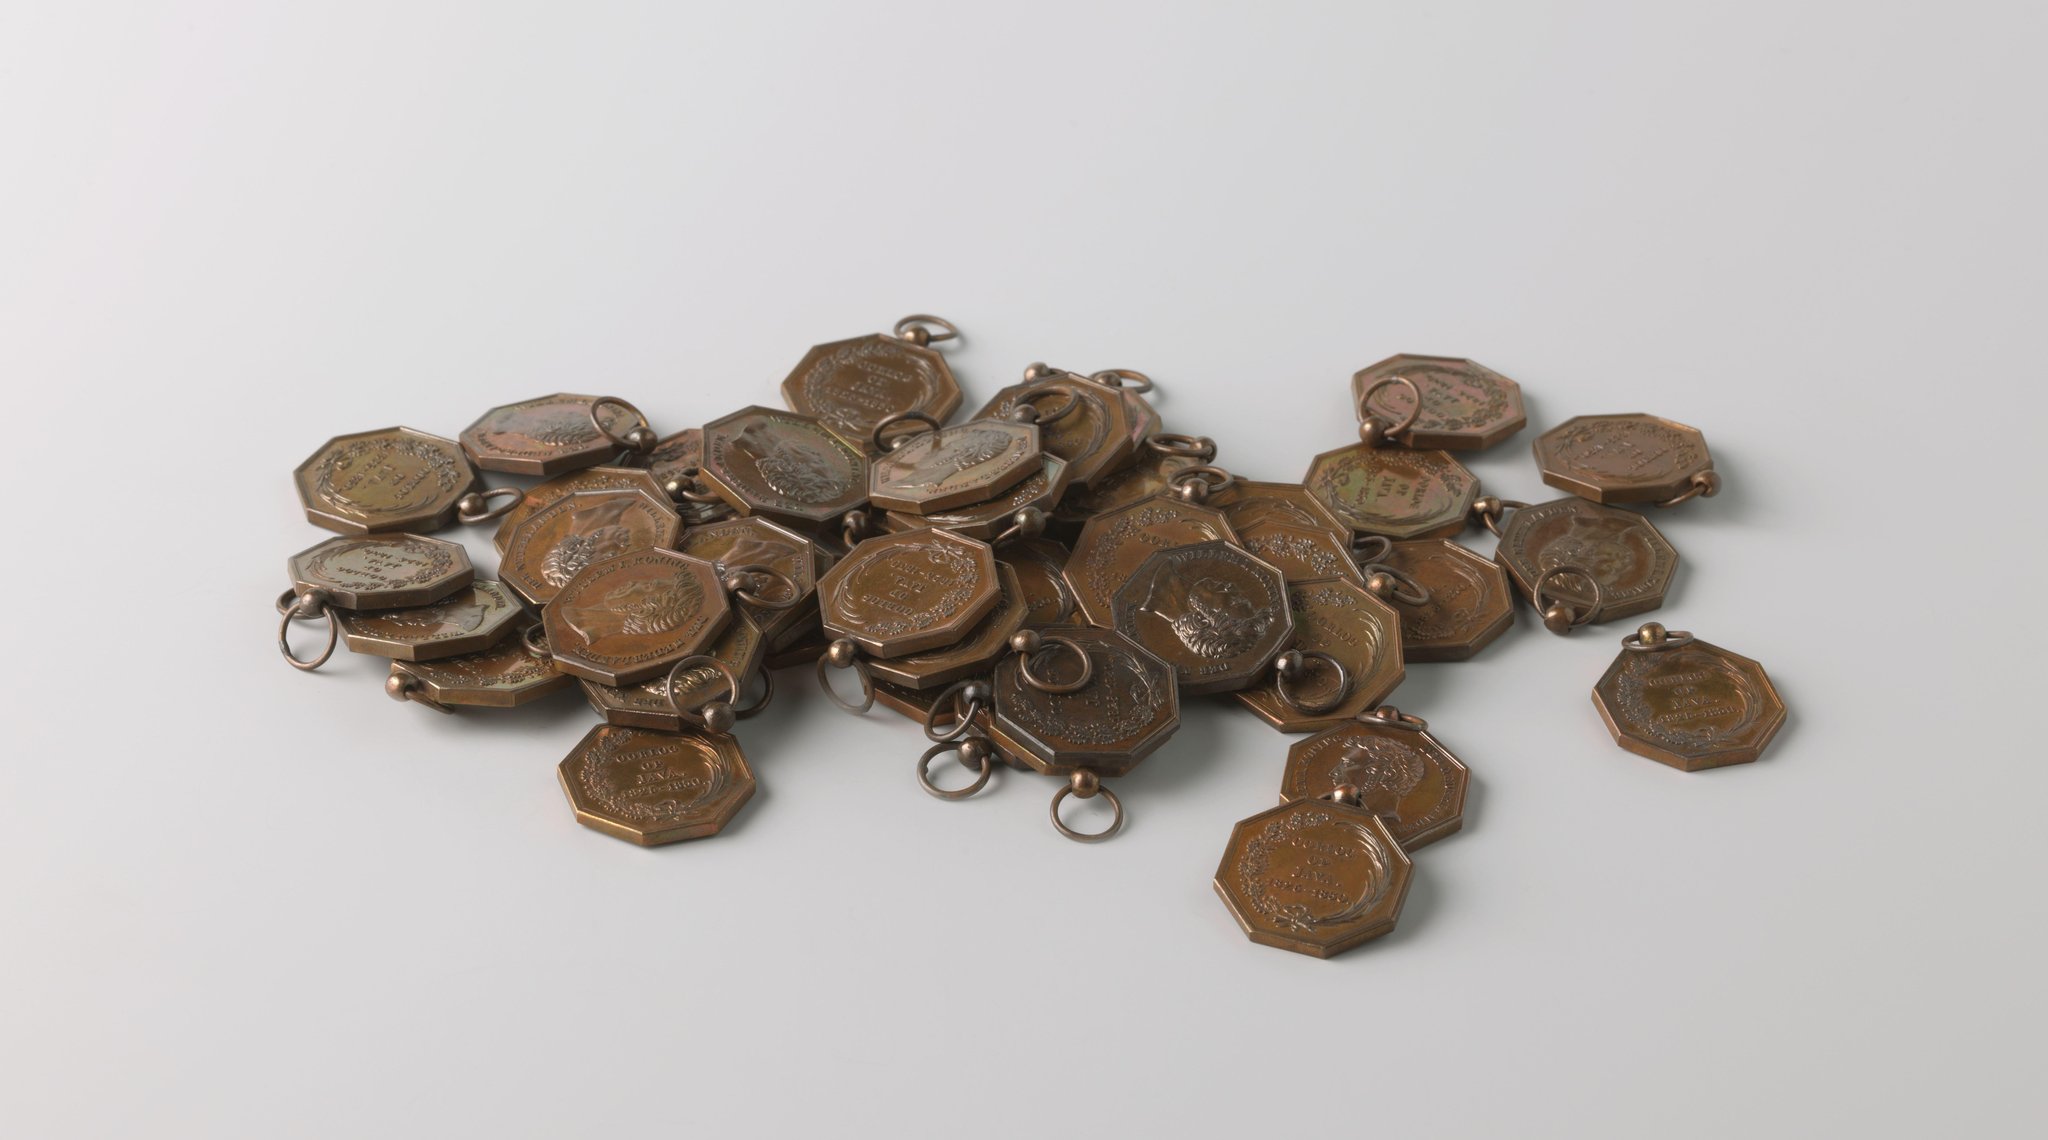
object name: insignia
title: Oorlog op Java, groot draagteken uitgereikt aan de deelnemers, ter ere van Willem I Frederik, koning der Nederlanden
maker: david van der kellen (1804-1879)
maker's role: die cutter, draughtsman, print maker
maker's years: 1804-1879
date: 1830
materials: bronze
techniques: striking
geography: utrecht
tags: the hague, berlin, william i of the netherlands, java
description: Achthoekig draagteken aan draagoog en draagring. Voorzijde: borststuk man binnen omschrift. Keerzijde: opschrift binnen tot krans samengebonden palm- en eiketak; twee aan draaglint.